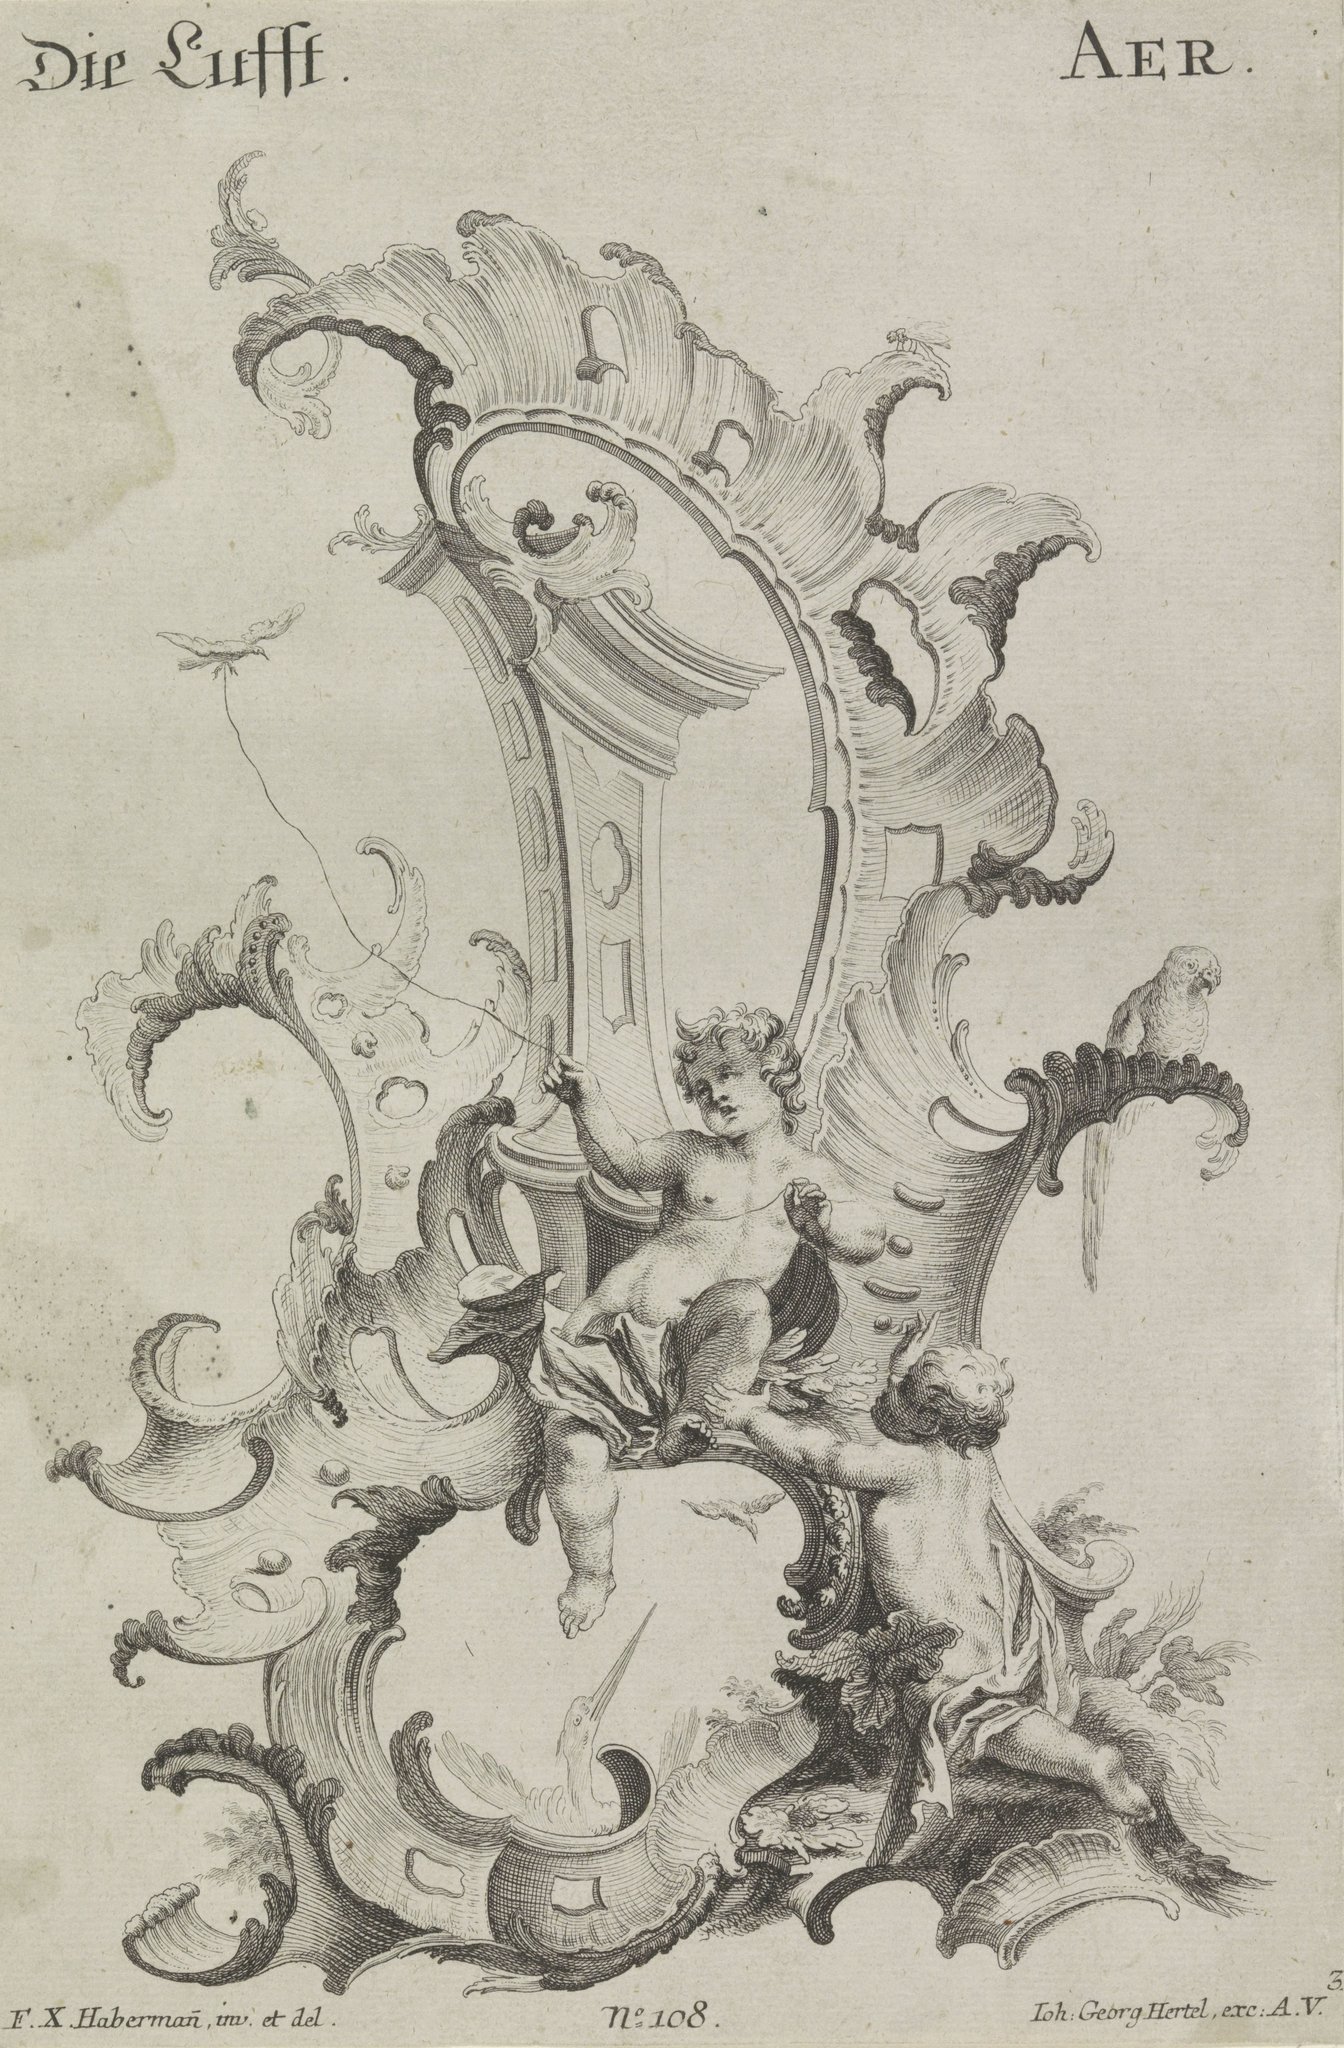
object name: ornament print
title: Die Lufft / Aer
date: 1731-1775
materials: paper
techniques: etching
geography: augsburg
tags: rocaille ornament, air (one of the four elements), cupids: 'amores', 'amoretti', 'putti'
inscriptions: collector's mark: Lugt 2760, collector's mark: Lugt 2228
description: In rocaille omraming het element lucht, vogels en twee putti. Uitgeversnummer 108